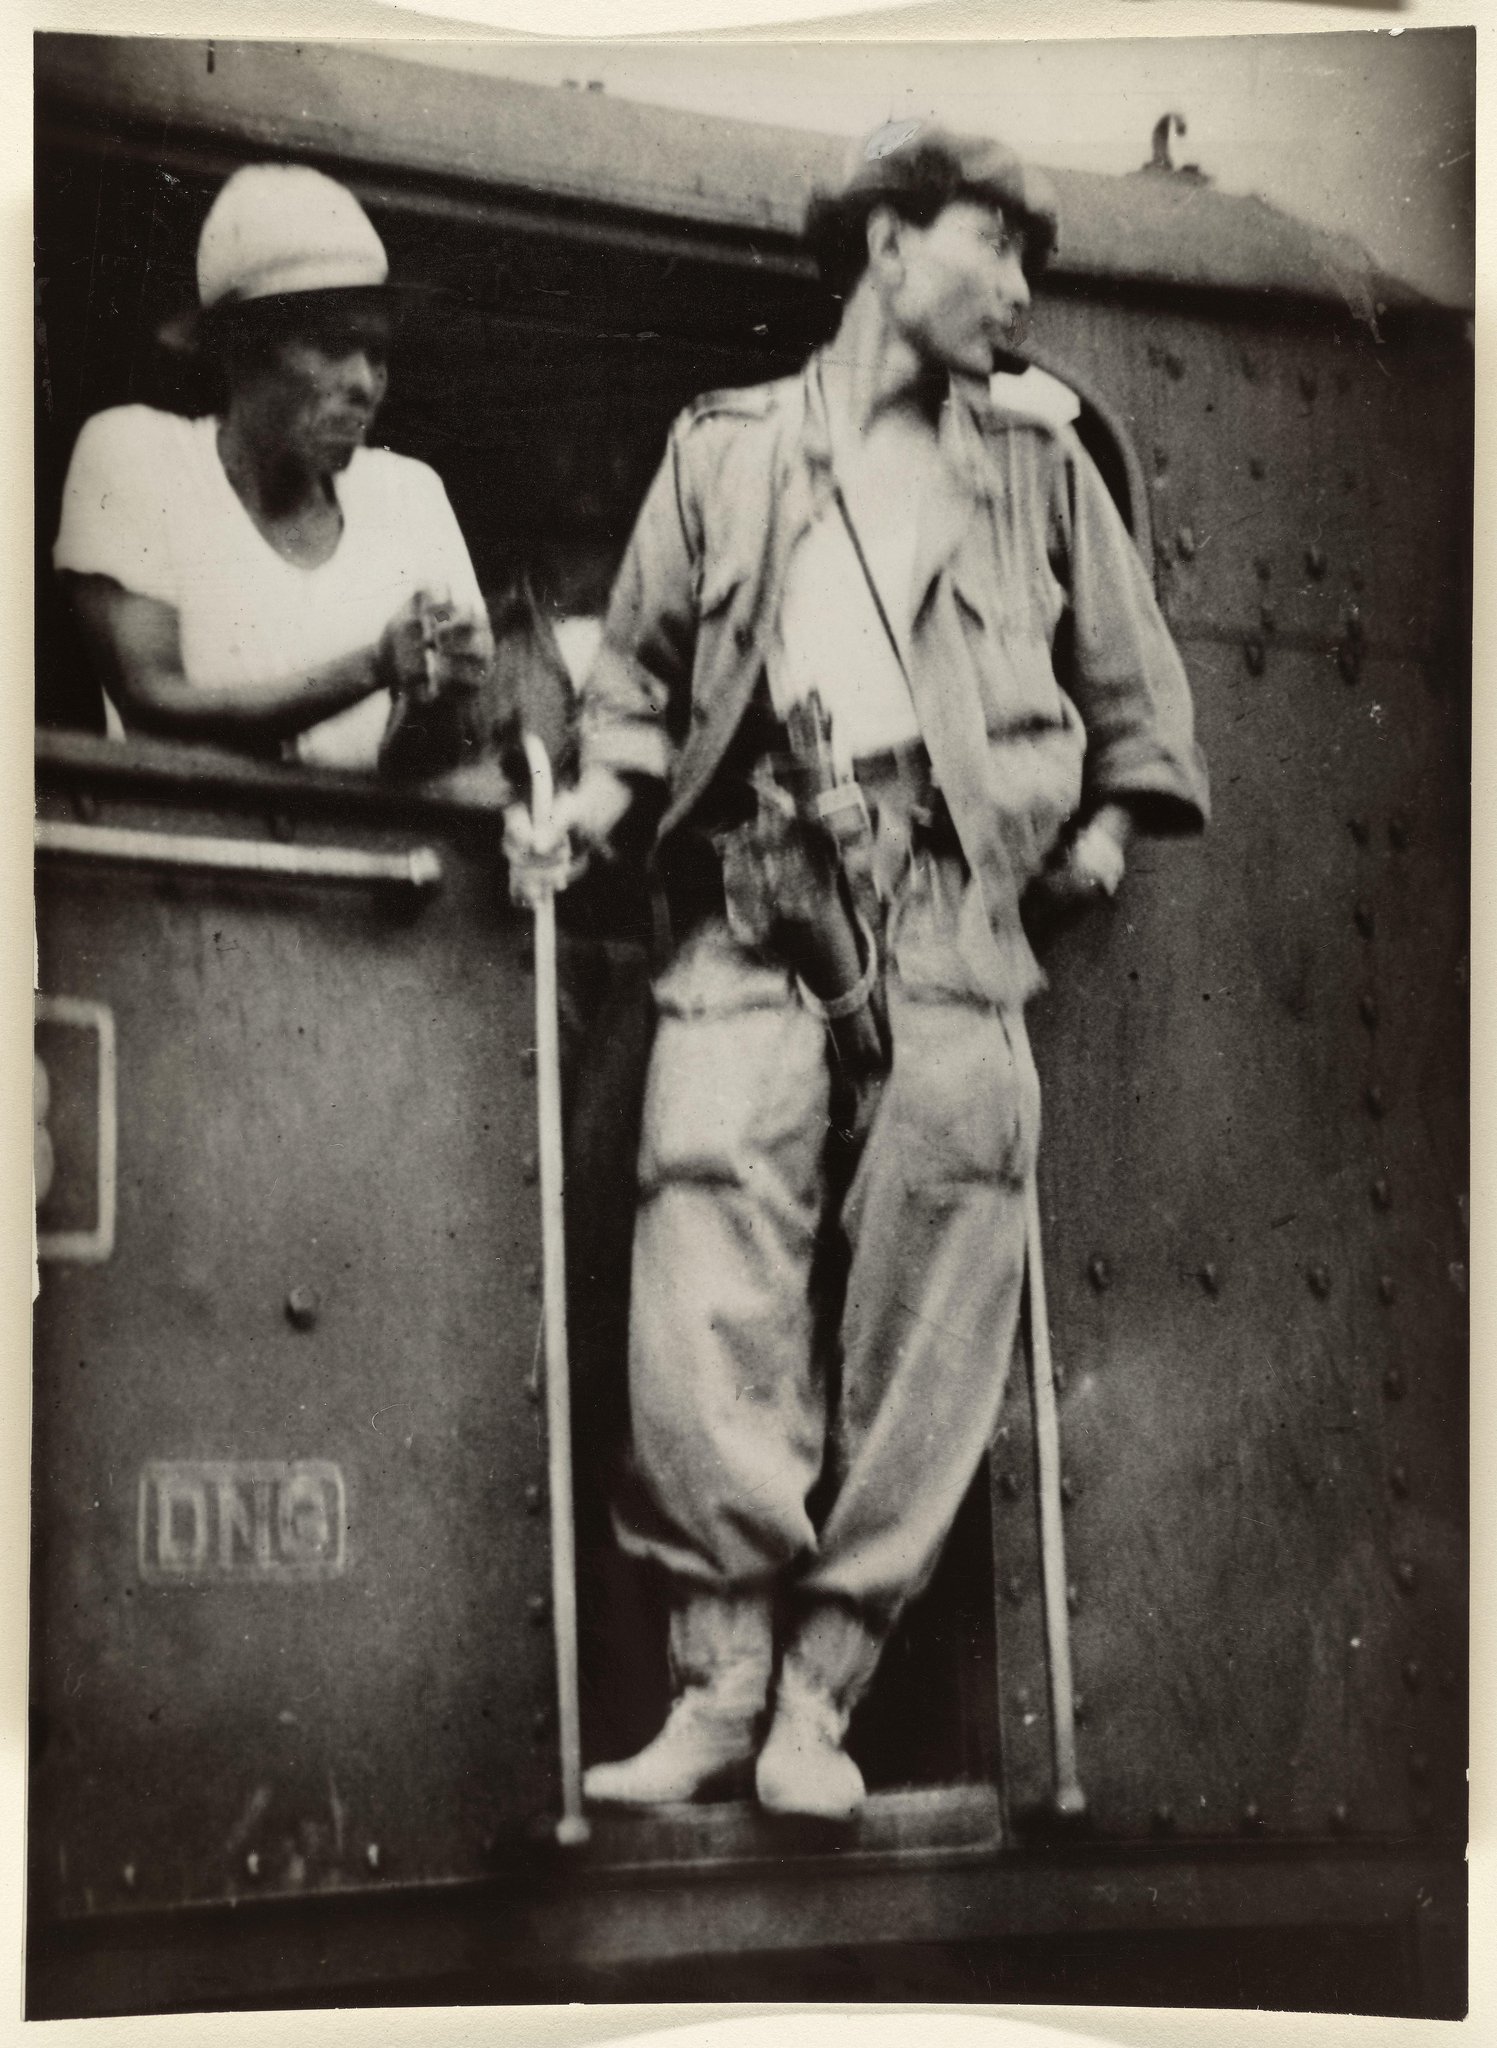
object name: documentary photograph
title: Republikeinse soldaat kaapt trein en machinist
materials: photographic support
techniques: photography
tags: indonesia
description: Republikeinse soldaat met geweer hangt uit de locomotief met naast hem de machinist (?) welke hij overmeestert en dwingt naar Tandjungrasa te rijden, alwaar de Republikeinse soldaten van de Siliwangi-divisie de trein plunderen.